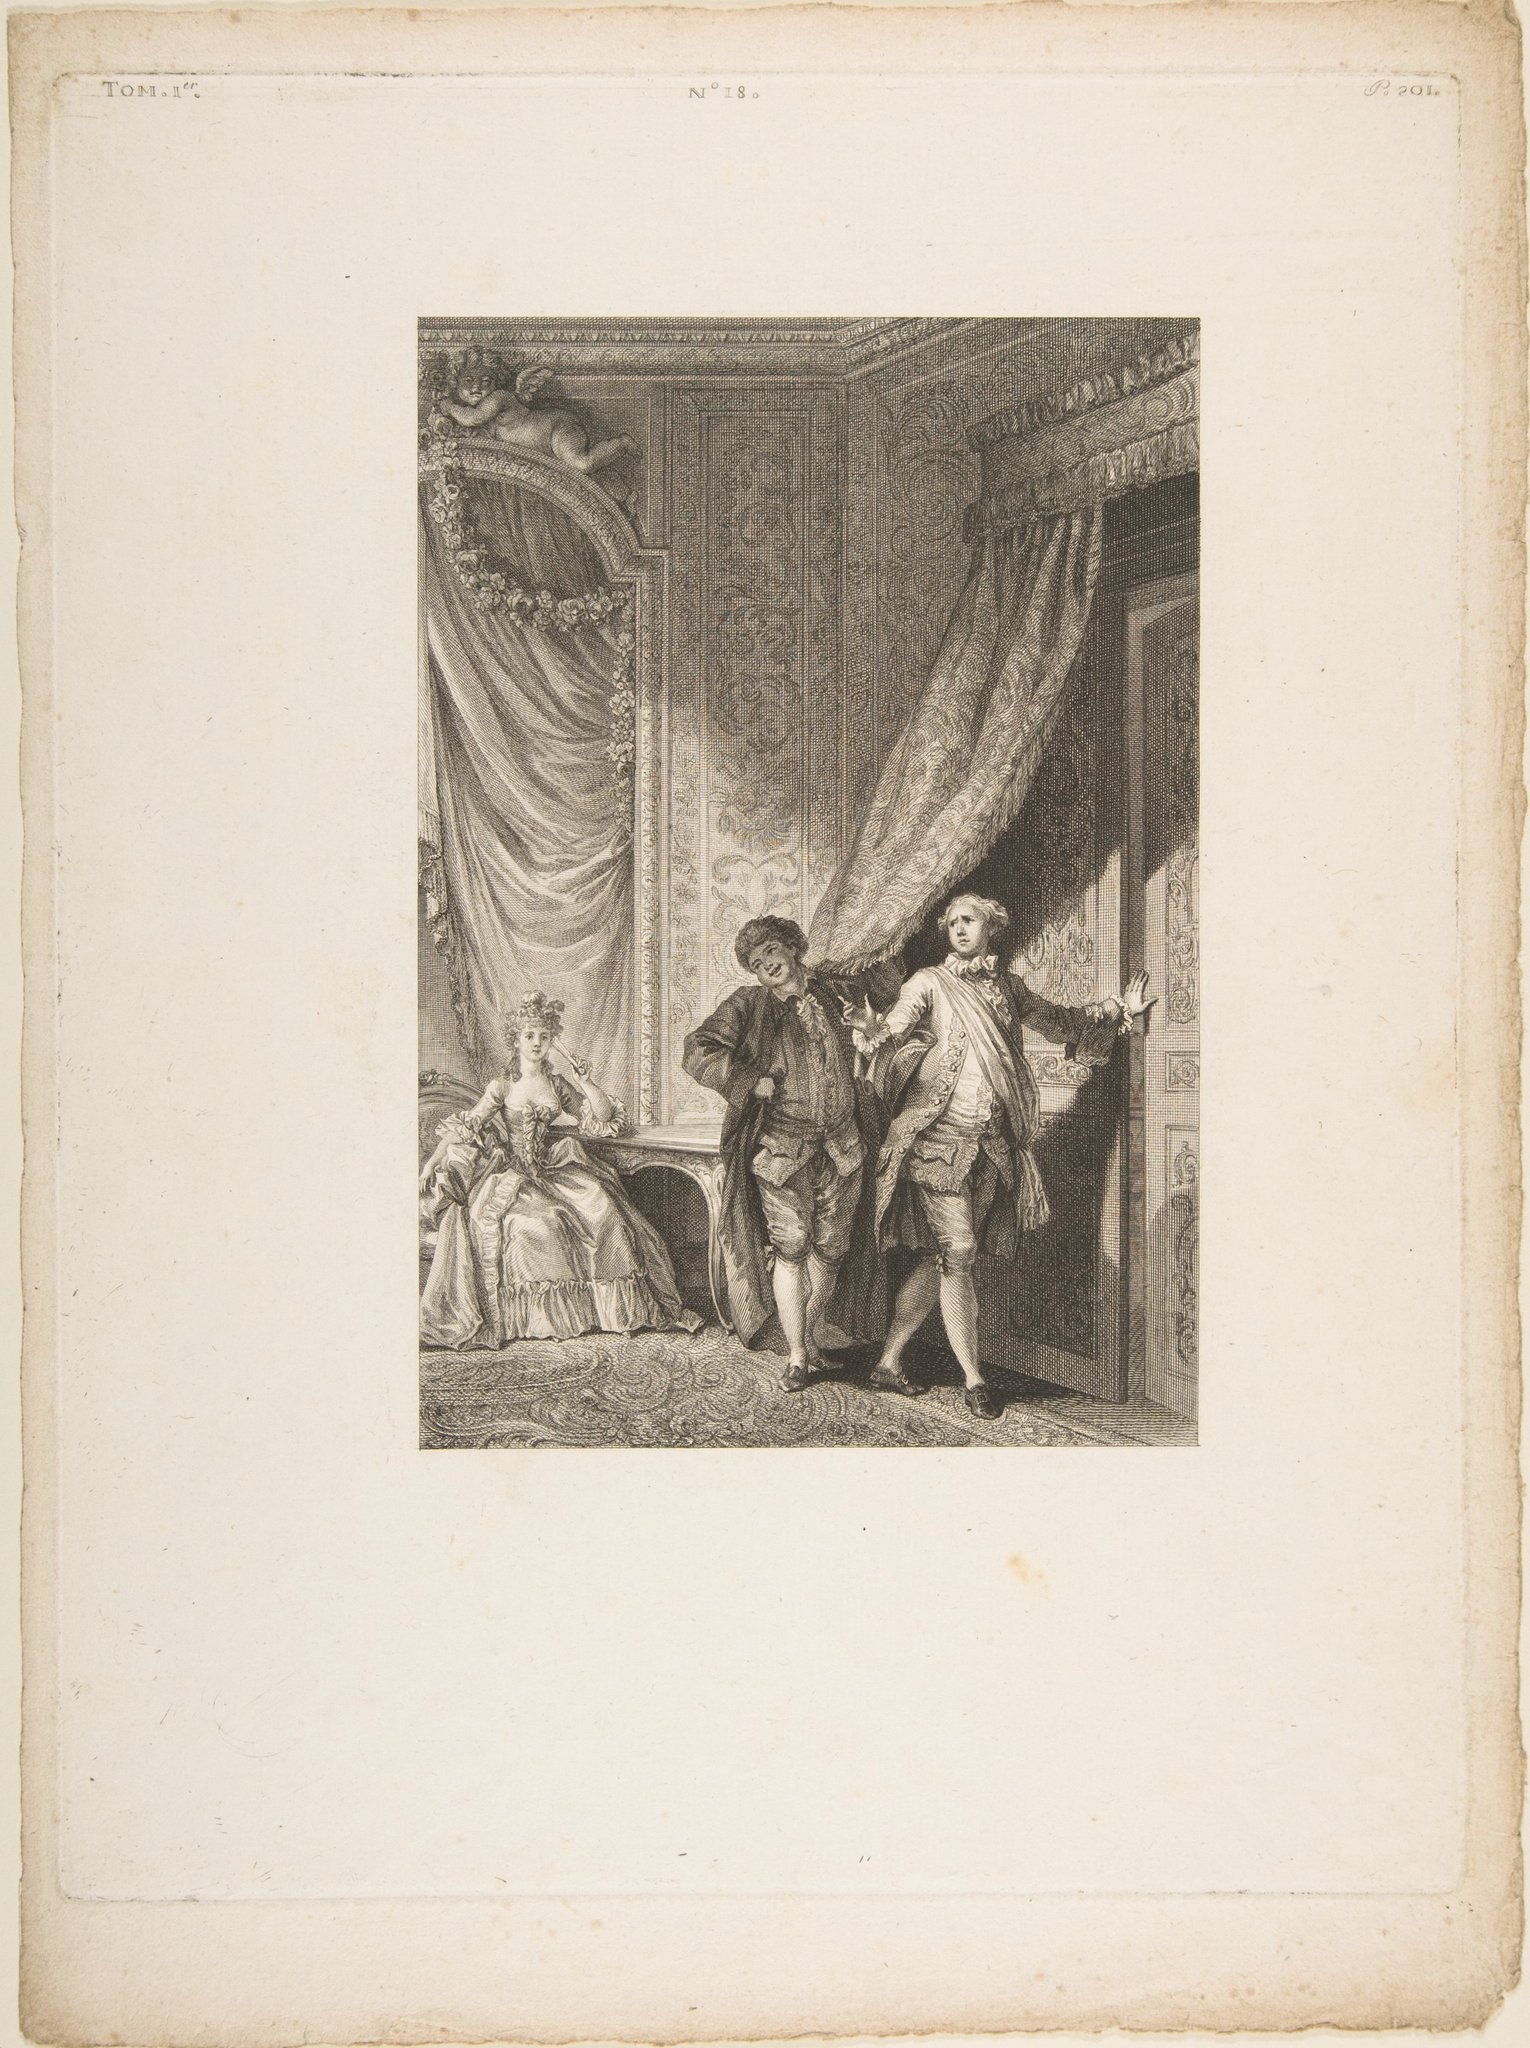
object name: print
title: Le Magnifique, from "Contes et nouvelles en vers par Jean de La Fontaine. A Paris, de l'imprimerie de P. Didot, l'an III de la République, 1795"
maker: jean-baptiste tilliard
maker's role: artist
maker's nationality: french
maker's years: 1740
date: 1795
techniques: engraving, etching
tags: interiors,men,women,putti